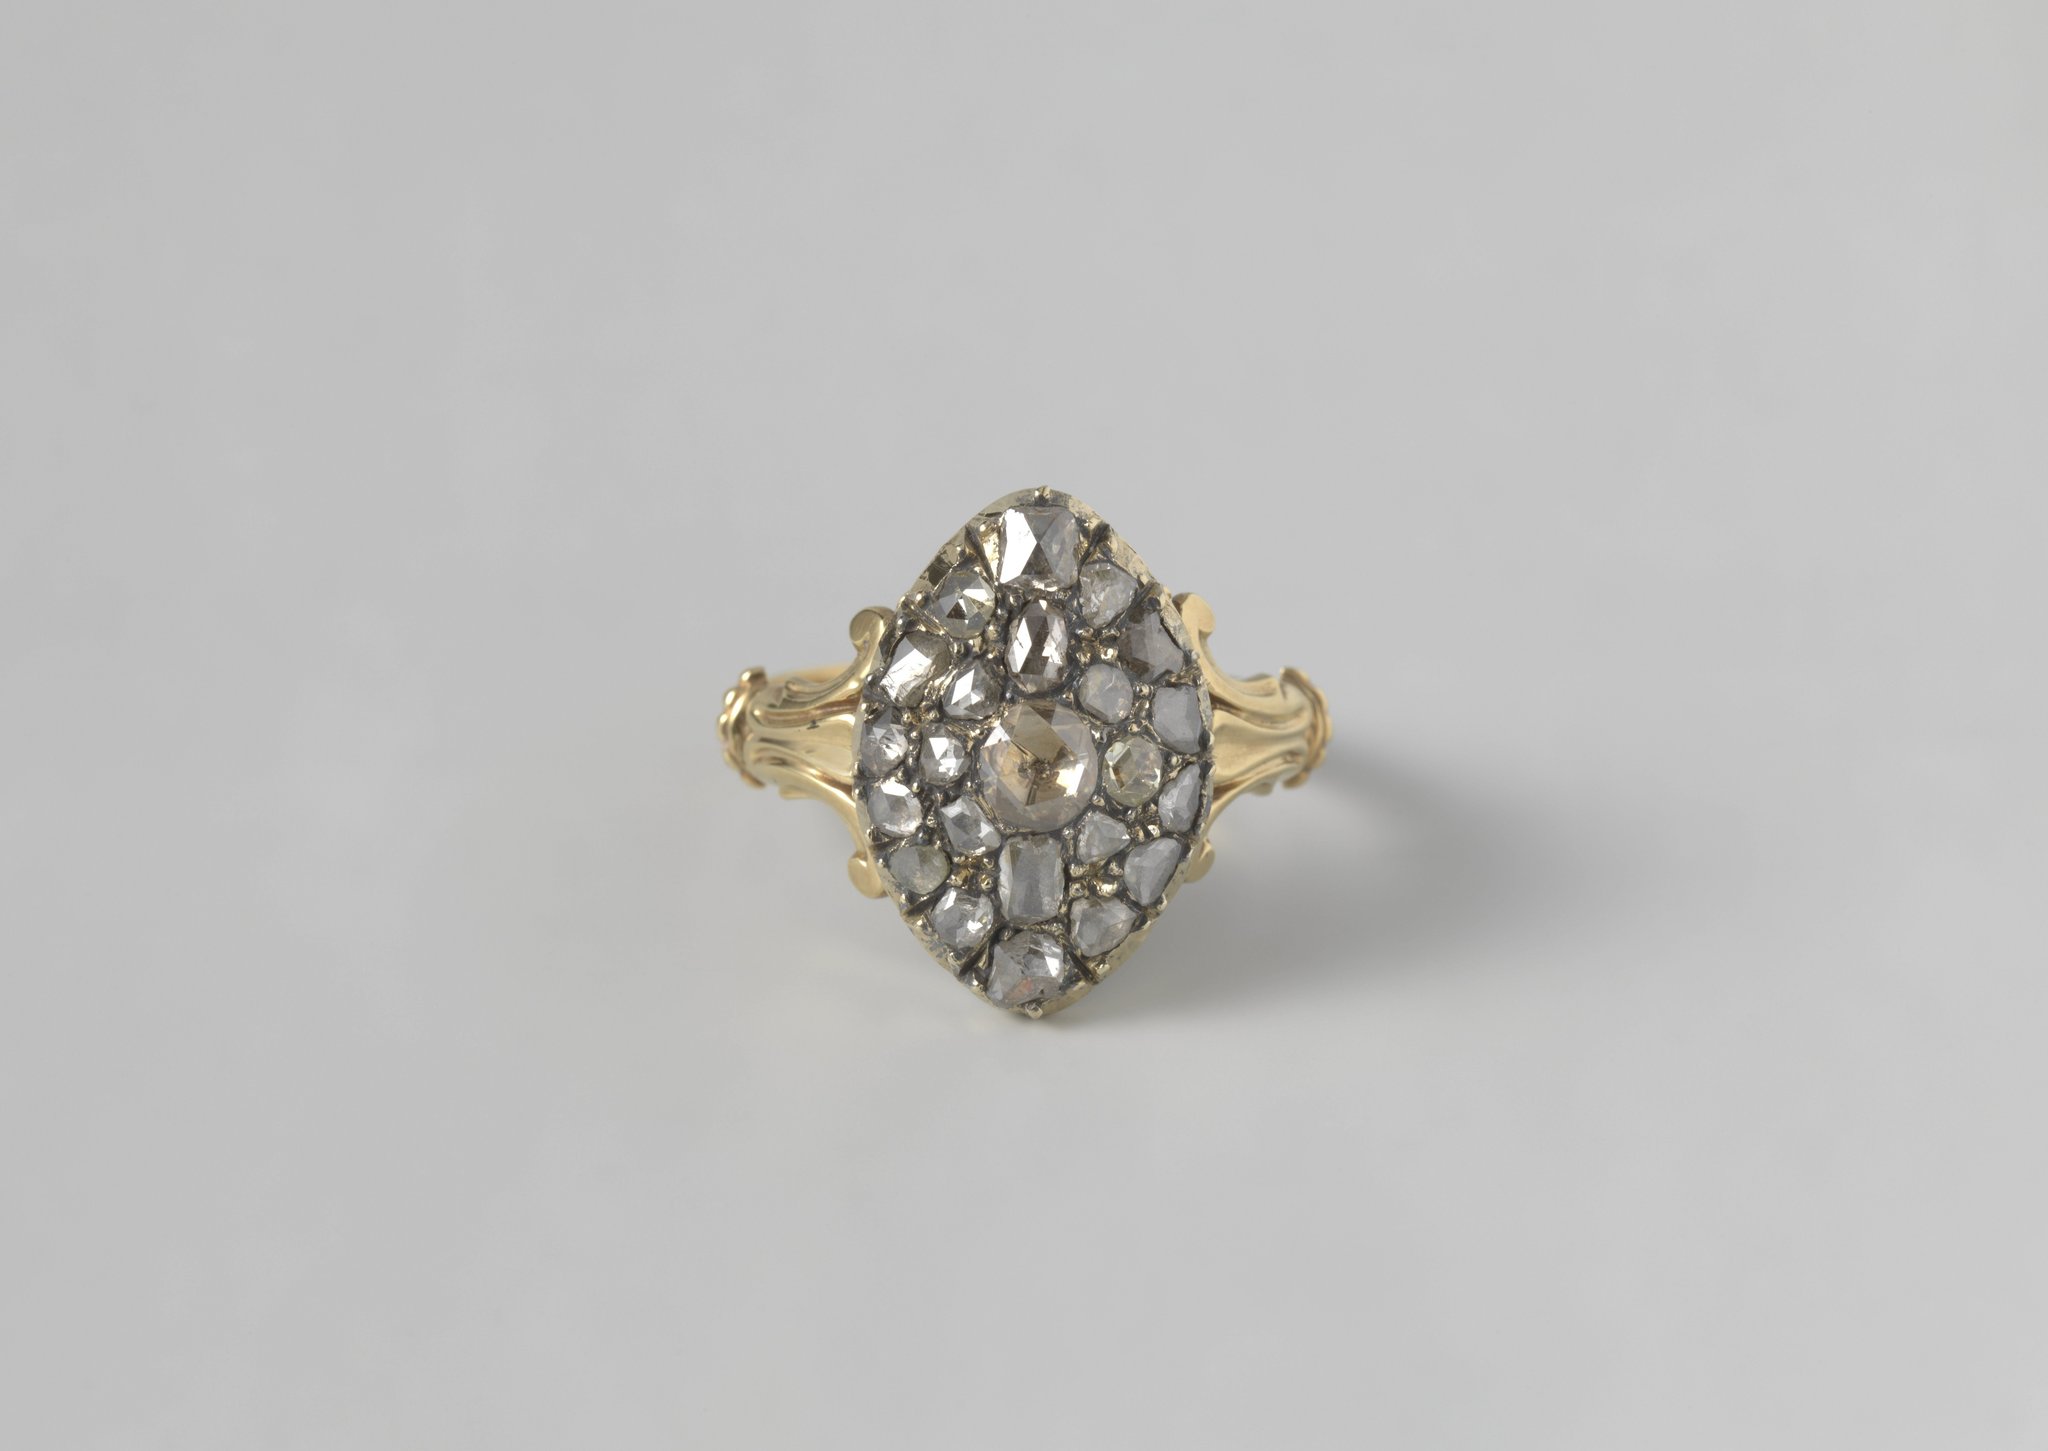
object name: ring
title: Entouragering met ovale hoep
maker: Anonymous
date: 1770-1800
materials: diamond, gold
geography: netherlands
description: Ring van goud. Met een ovaal sierstuk dat geheel bezet is met diamanten.